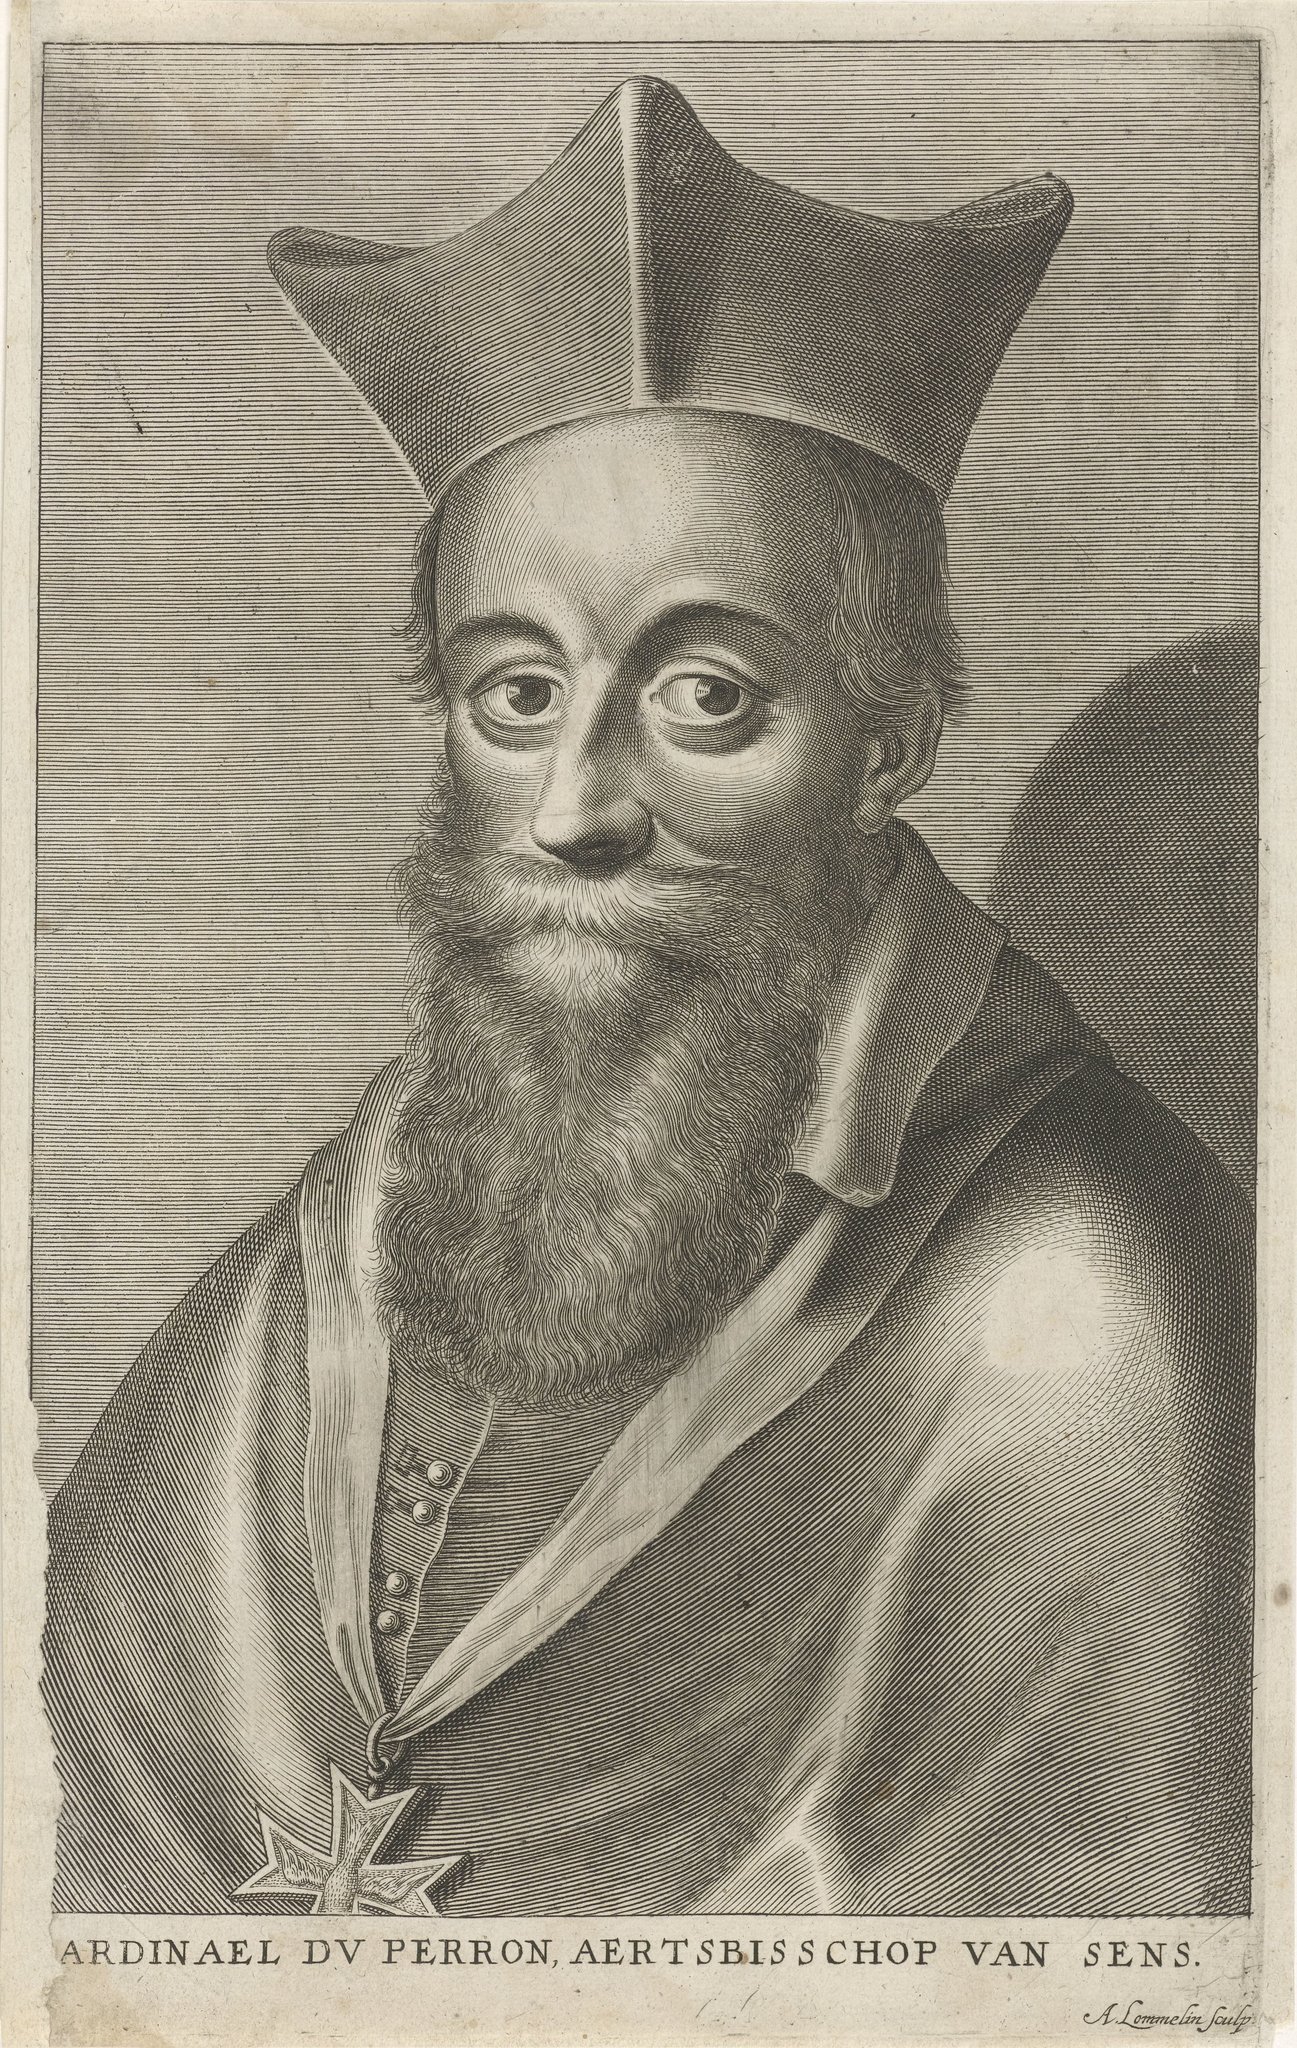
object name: print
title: Portret van Adriaen du Perron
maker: adriaen lommelin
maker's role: print maker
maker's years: 1618-1675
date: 1630-1677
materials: paper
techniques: engraving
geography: antwerp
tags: kardinaal, adriaen du perron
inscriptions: collector's mark: Lugt 240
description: Portret van kardinaal Adriaen du Perron, aartsbisschop van Sens (Frankrijk).